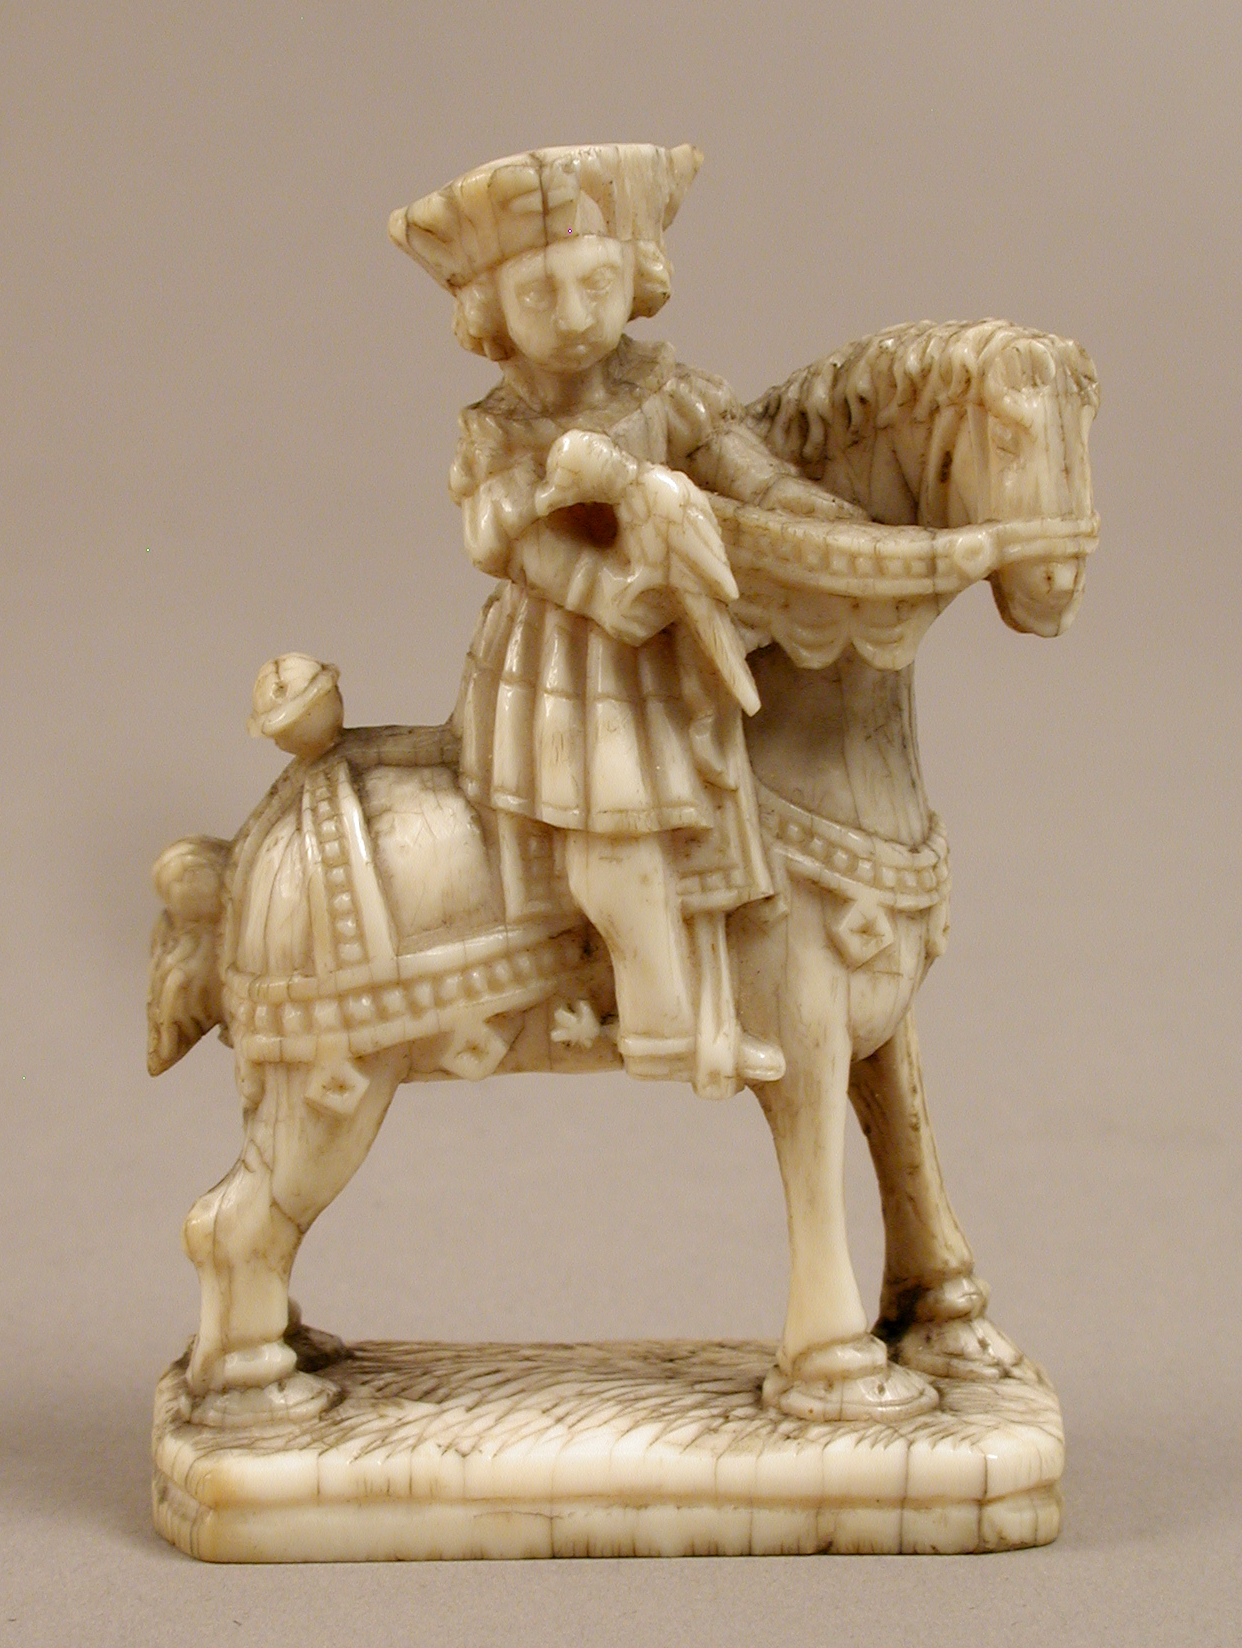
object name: chess piece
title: Chess Piece in the Form of a Knight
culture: dutch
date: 1500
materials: ivory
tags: horses,knights